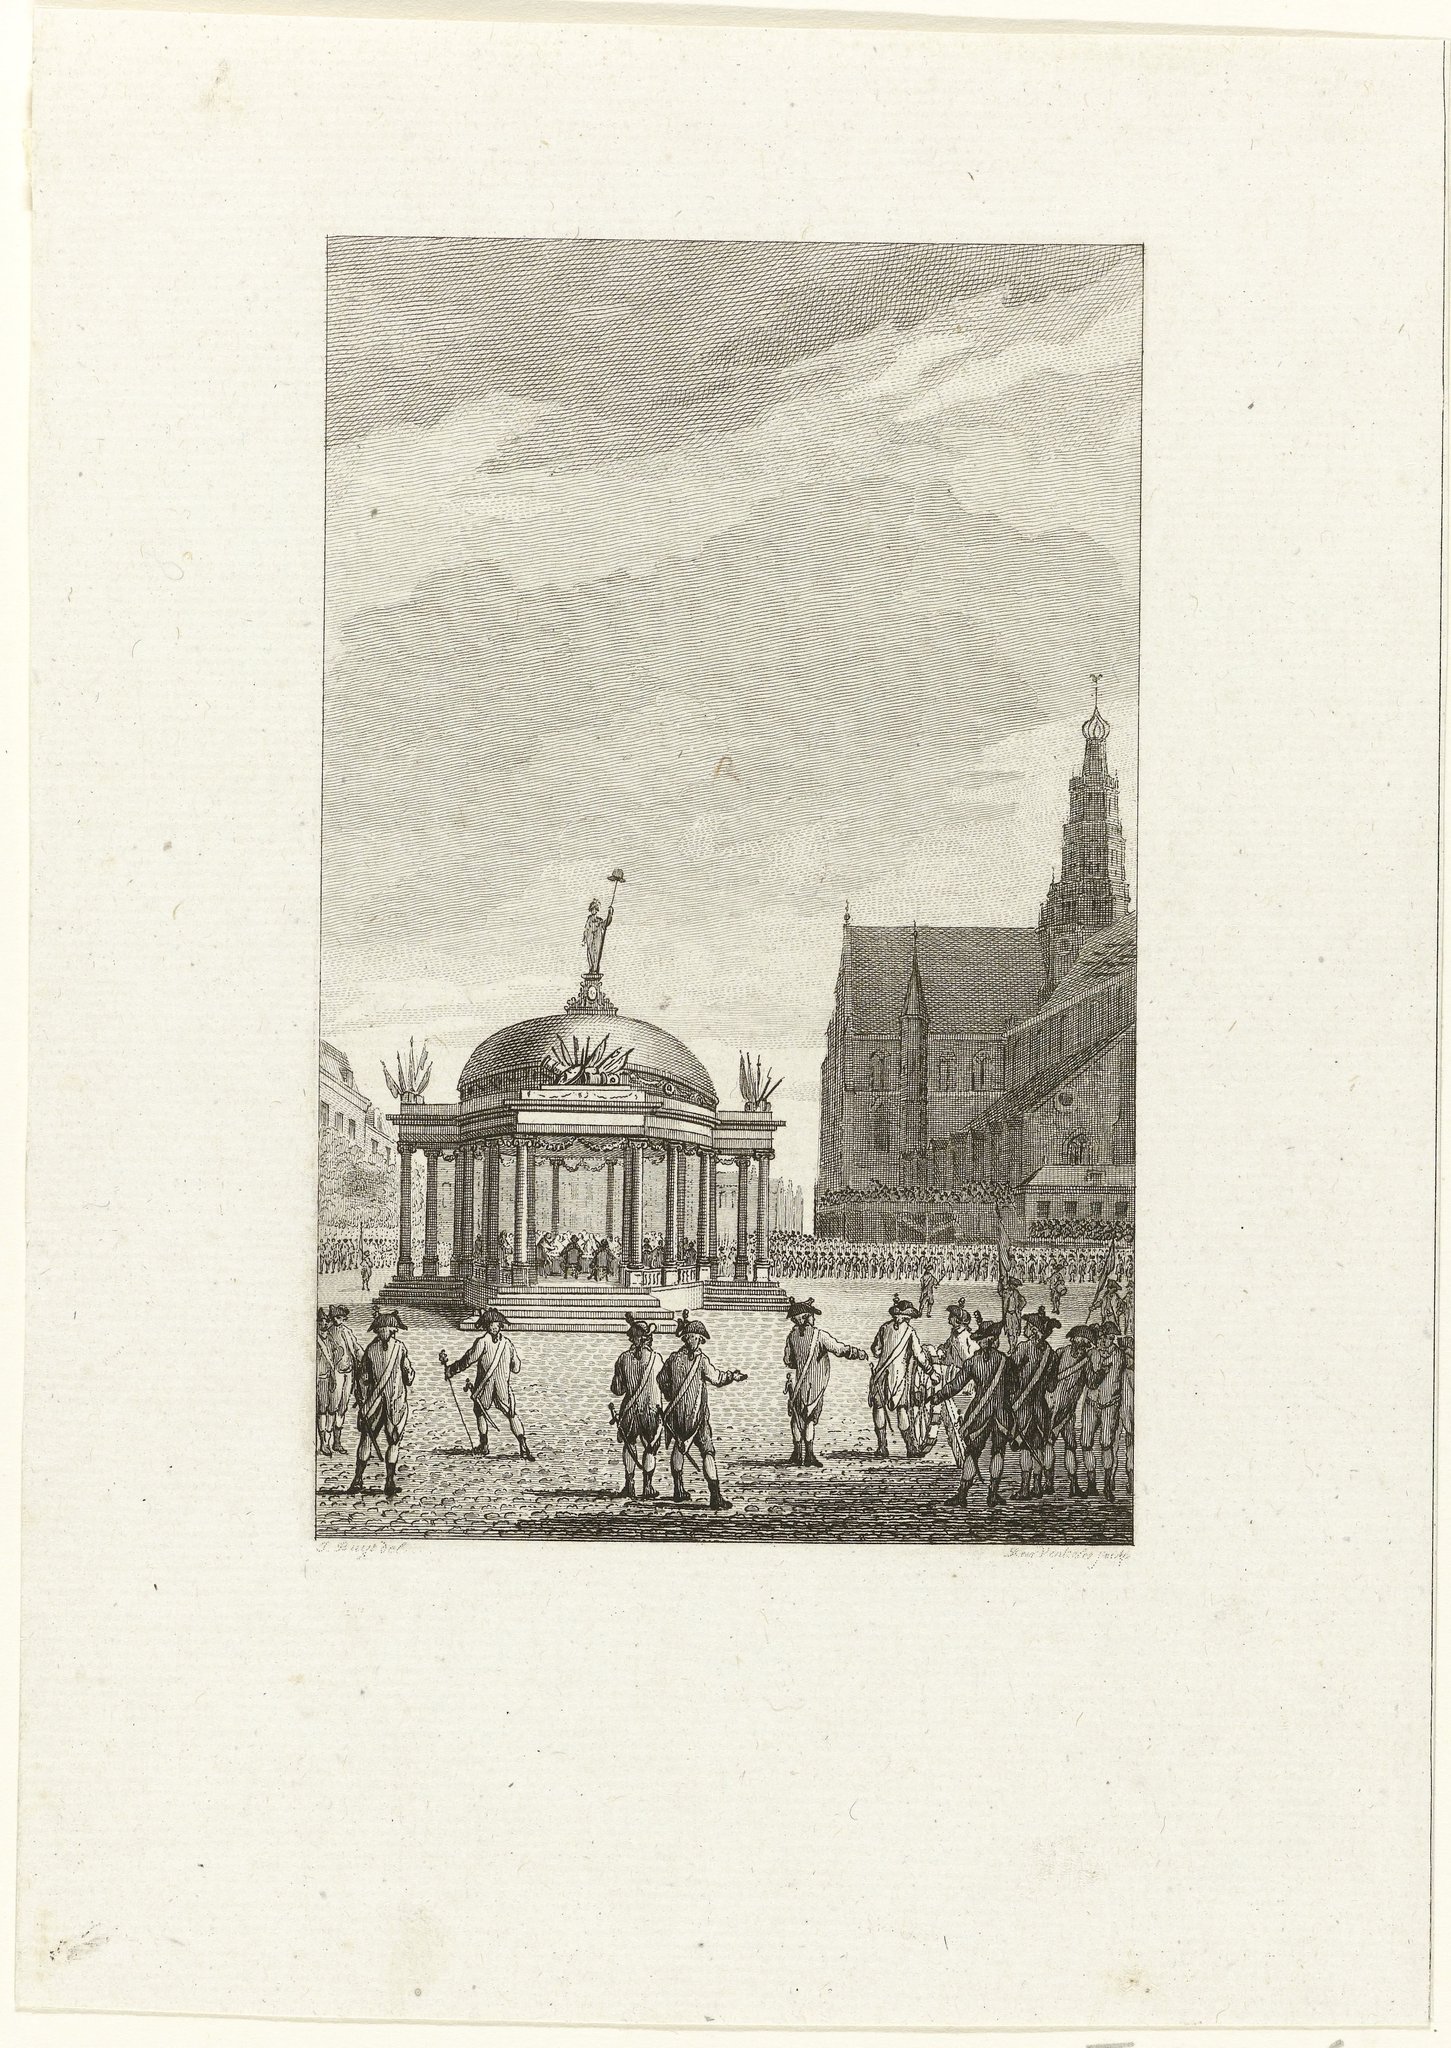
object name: print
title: Beëdiging van het regeringsreglement in Haarlem, 1787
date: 1795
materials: paper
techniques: engraving, etching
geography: northern netherlands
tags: proclamation of new government, warfare; military affairs (+ citizen soldiery, civil guard, citizen militia), patriots (1780-1795)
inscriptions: collector's mark: Lugt 2228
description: Gebruikt als illustratie in: P.A. Loosjes. Vaderlandsche historie, vervattende de geschiedenissen, der Vereenigde Nederlanden (...). Ten onmiddelyken vervolge van Wagenaar's Vaderlandsche historie. Amsterdam: Johannes Allart, dl. 15.